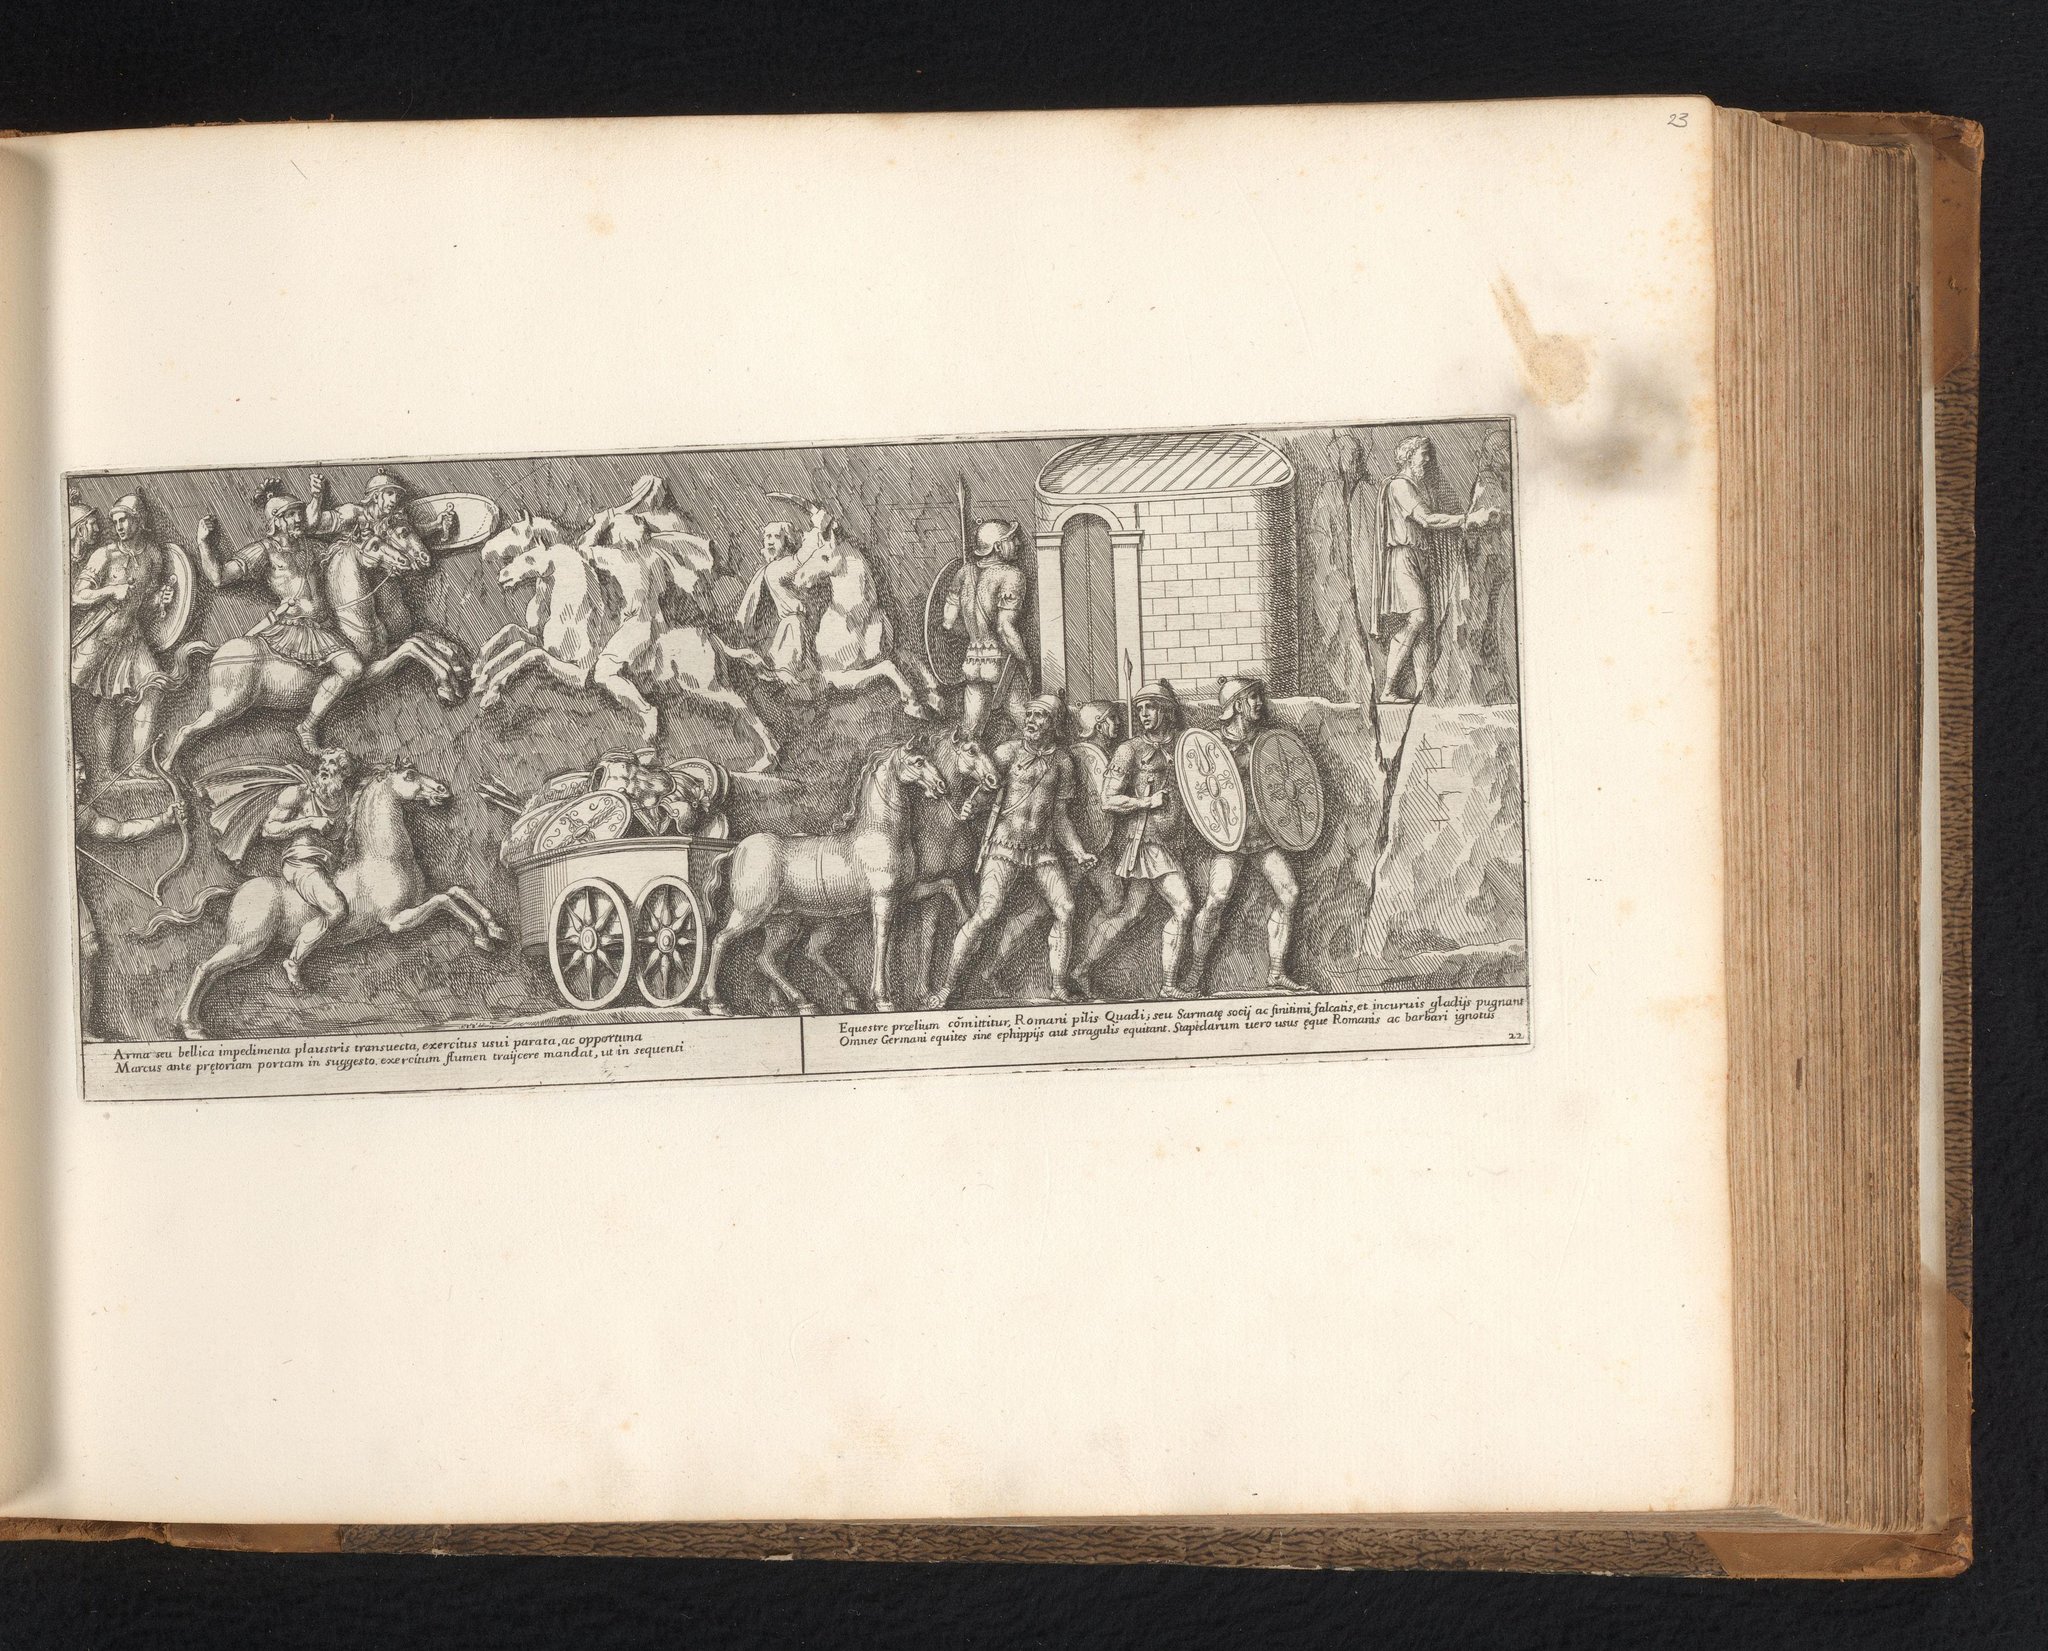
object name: album leaf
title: Detail van het fries op de Zuil van Marcus Aurelius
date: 1672-1675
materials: paper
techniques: etching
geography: rome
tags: triumphal column with helical friezes, piece of sculpture, reproduction of a piece of sculpture, the soldier; the soldier's life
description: Detail van het spiraalvormige gebeeldhouwde fries op de Zuil van Marcus Aurelius te Rome. Het fries toont de oorlog tussen het Romeinse leger van keizer Marcus Aurelius en de Germaanse stammen der Marcomannen en Quaden en de oorlog tegen de Sarmaten die vanuit het huidige Iran Hongarije waren binnengevallen. Tekst in de ondermarge. Prent maakt deel uit van een album.